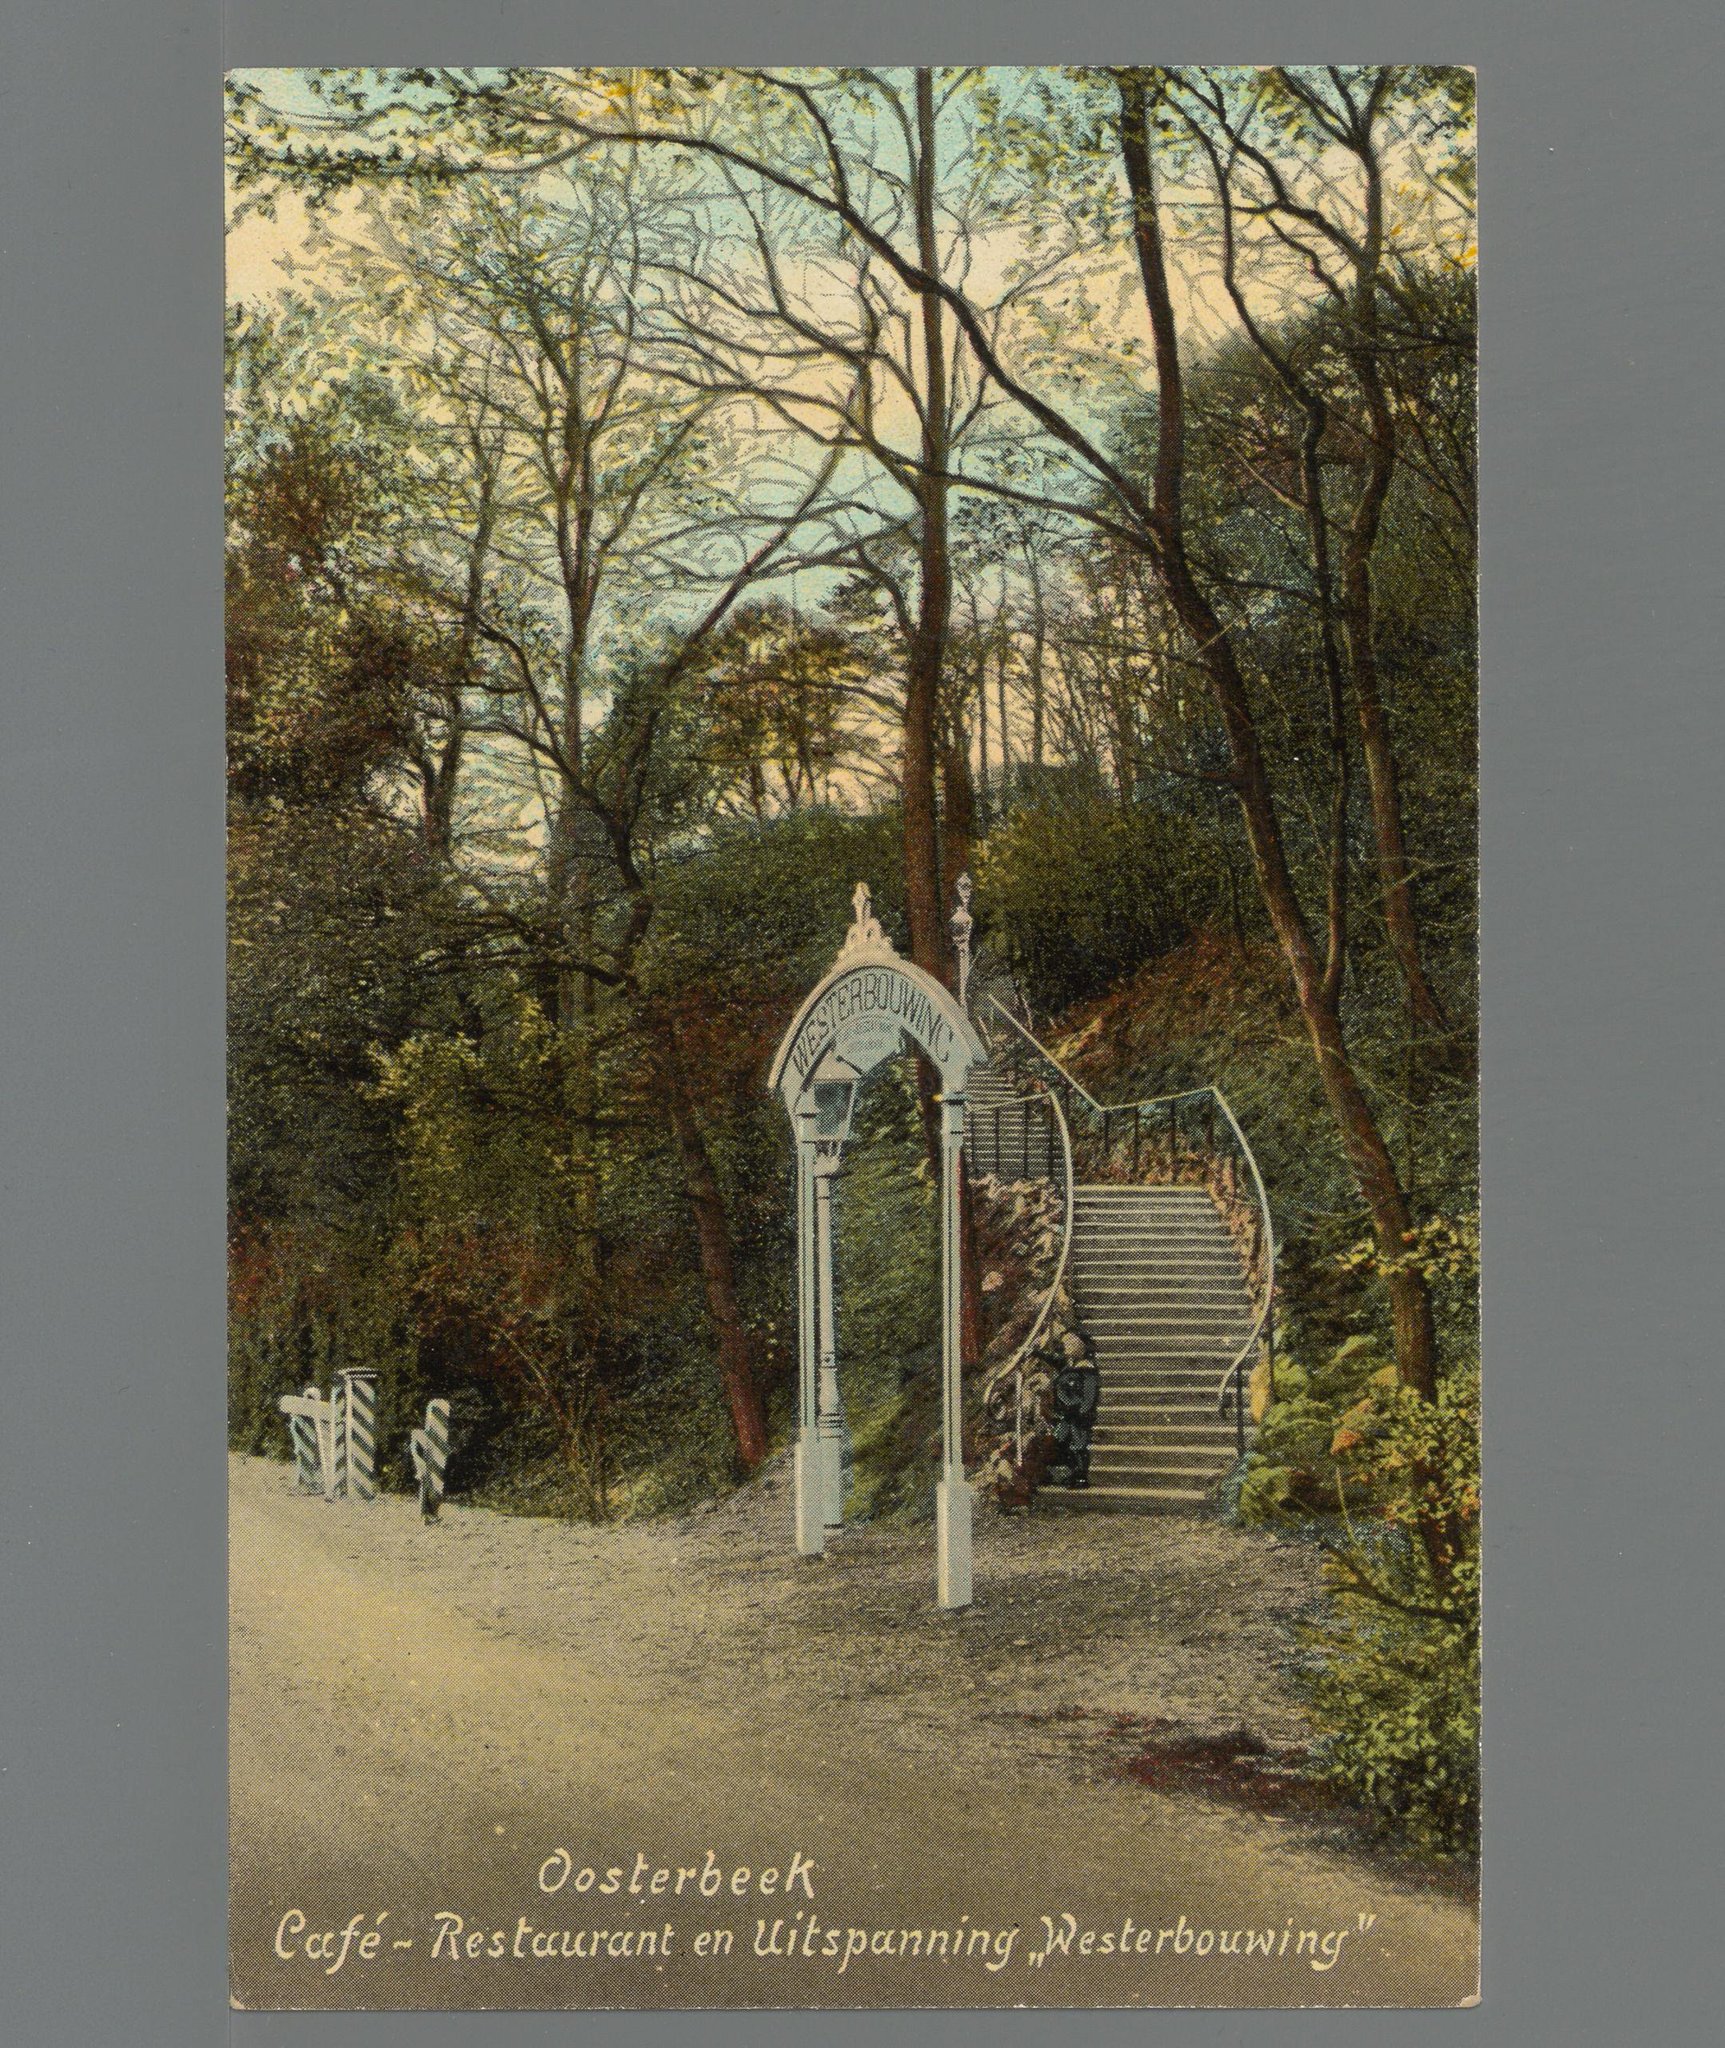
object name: photomechanical print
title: Oosterbeek. Café-Restaurant en Uitspanning "Westerbouwing"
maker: Anonymous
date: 1909-1918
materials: cardboard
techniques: lithograph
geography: the hague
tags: gate, entrance, restaurant